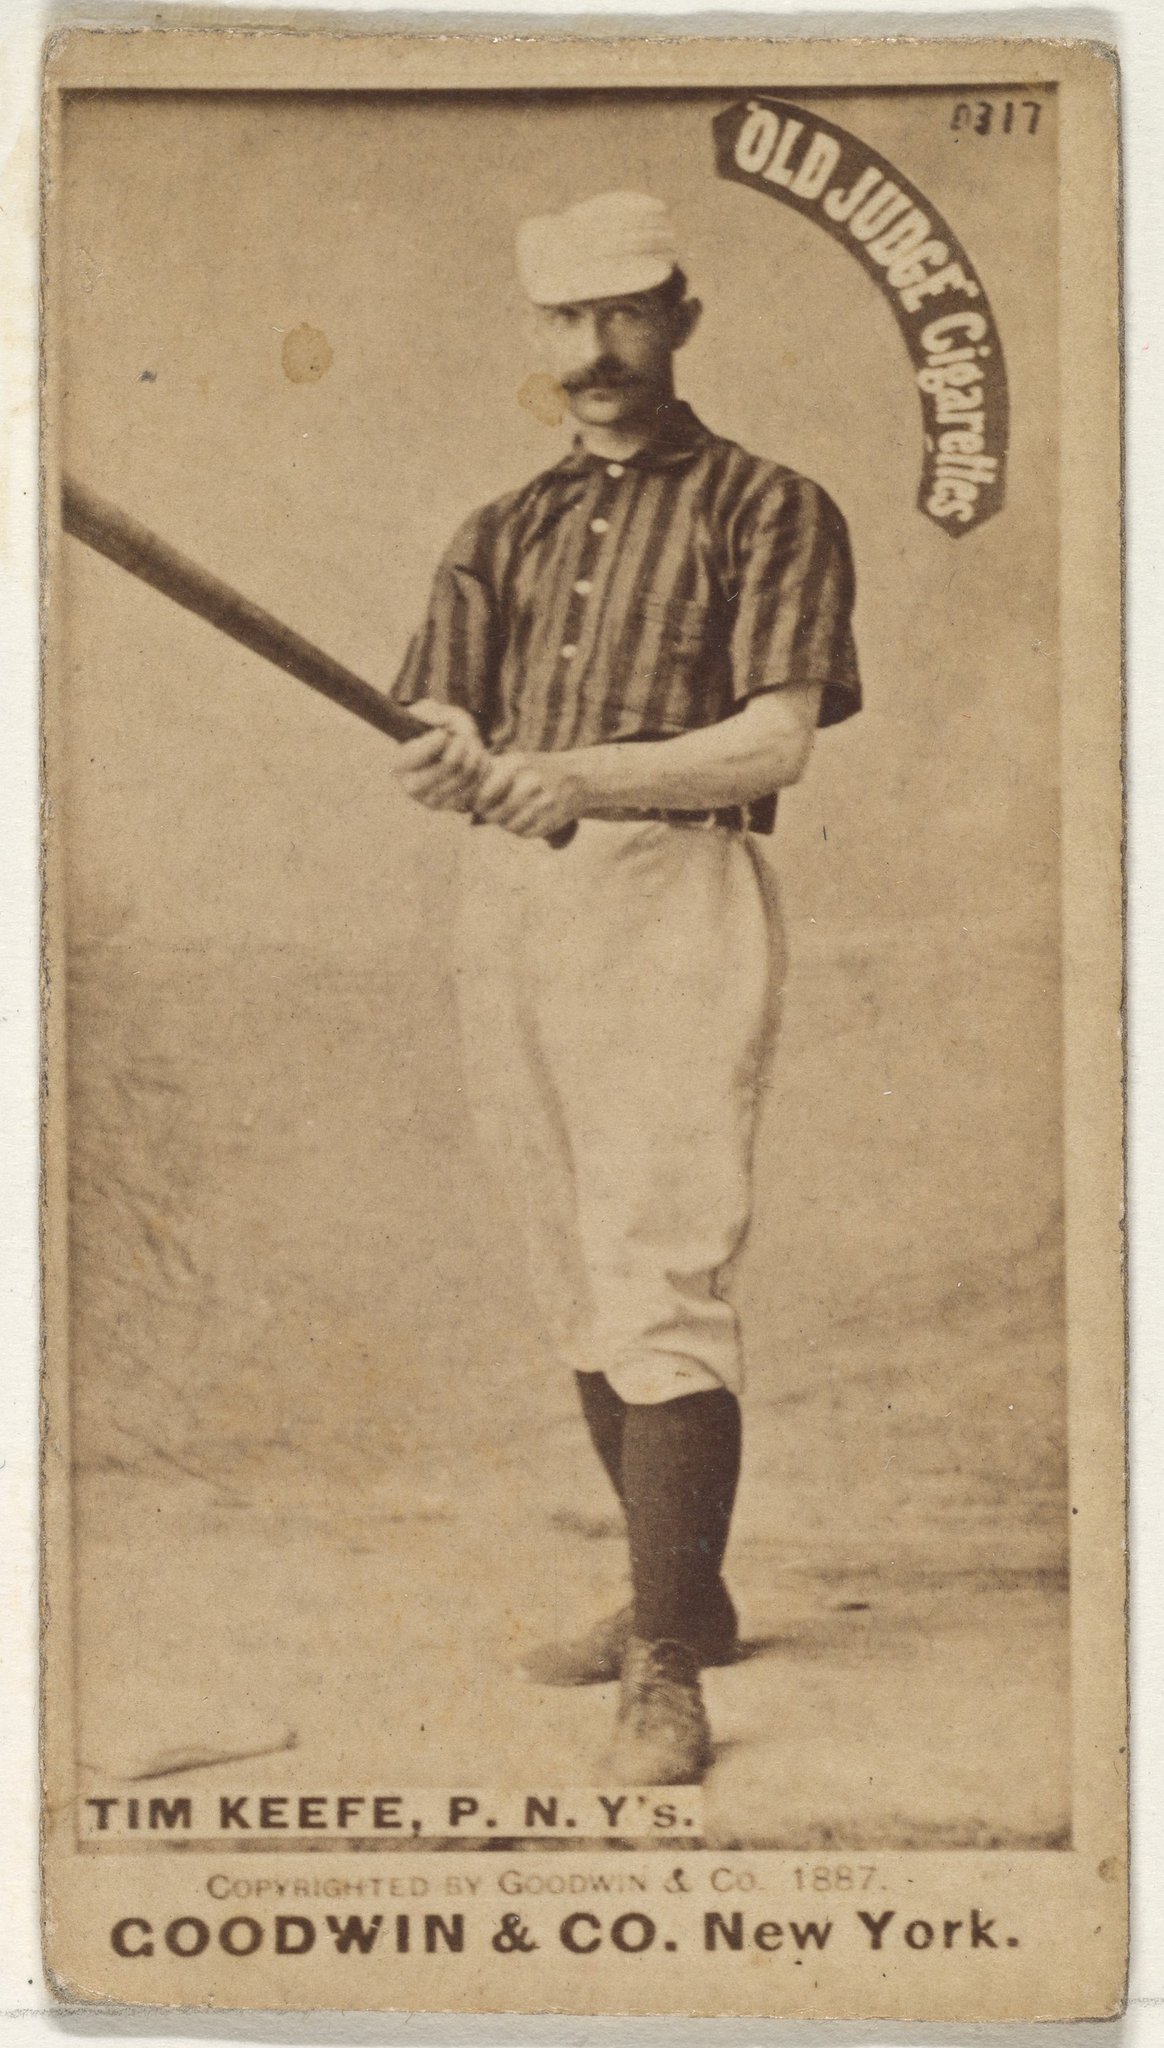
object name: baseball card, photograph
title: Timothy John "Tim" Keefe, Pitcher, New York, from the Old Judge series (N172) for Old Judge Cigarettes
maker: goodwin & company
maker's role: publisher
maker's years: 1850-1950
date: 1887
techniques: albumen silver print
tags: men,portraits,baseball,athletes